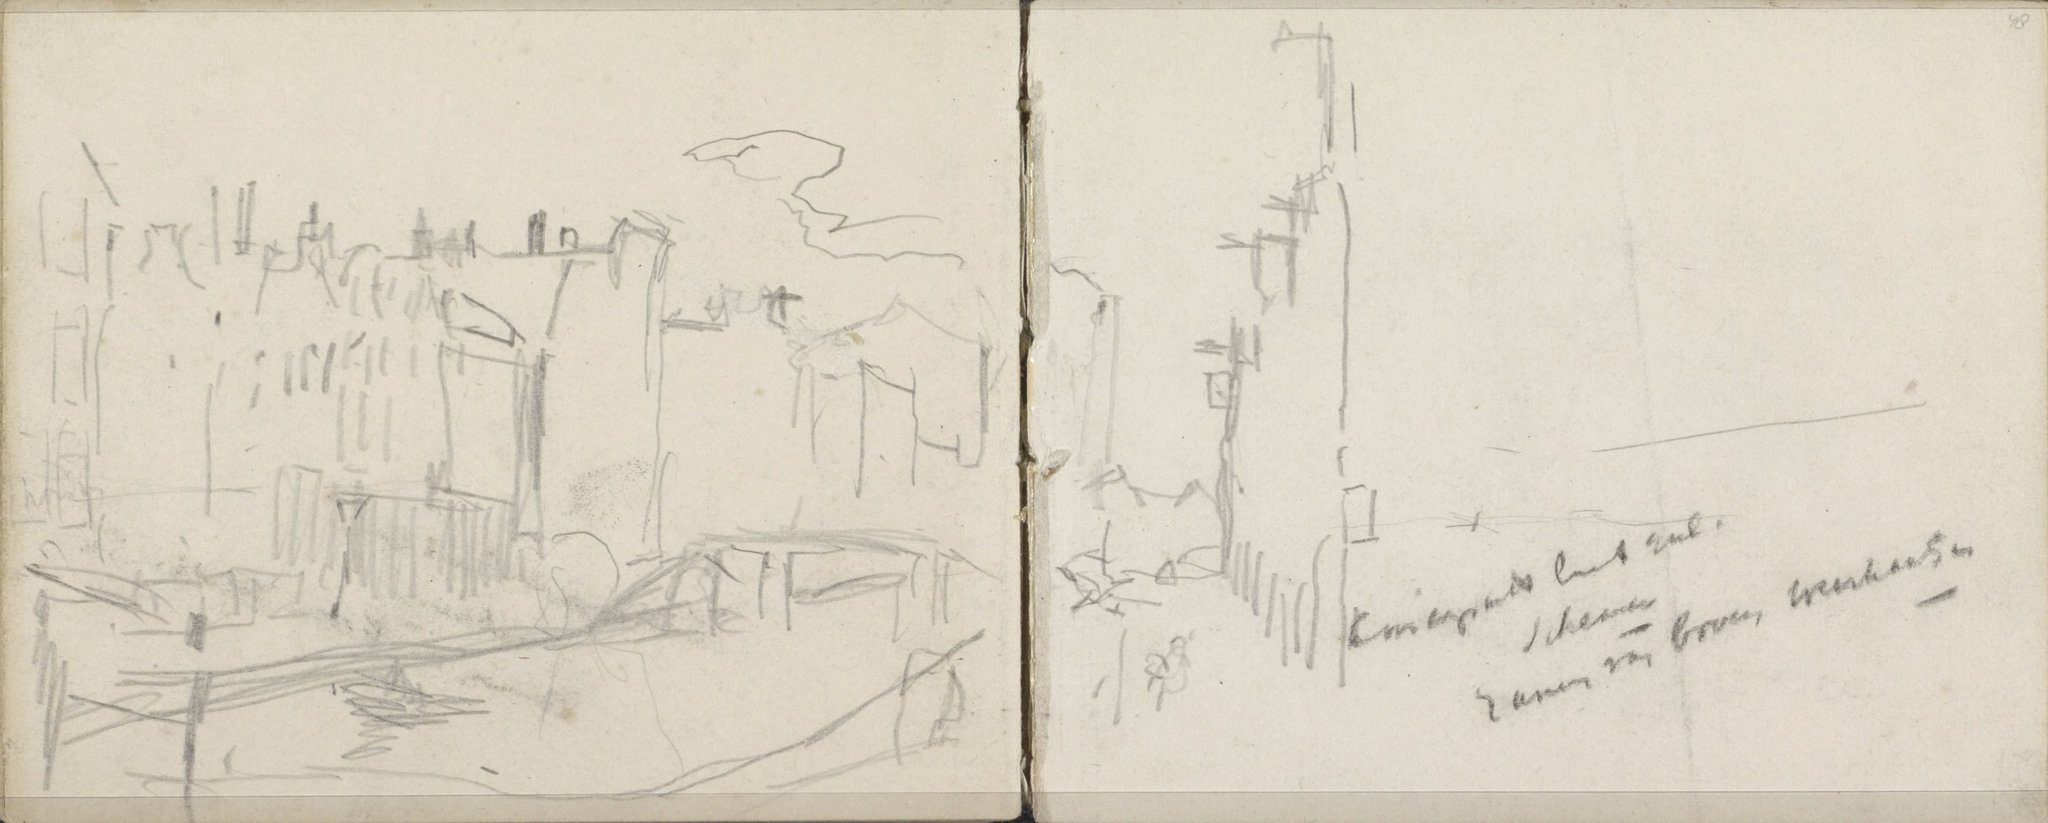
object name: sketchbook leaf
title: Looiersgracht te Amsterdam bij avond, gezien vanaf de Prinsengracht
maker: george hendrik breitner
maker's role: draughtsman, painter, print maker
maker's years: 1857-1923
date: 1886-1891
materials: paper, pencil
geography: amsterdam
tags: urban housing, canals, waters (in city)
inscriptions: annotation: ‘Looiergracht [sic] licht geel./ schemer/ ramen van boven weerkaatsen’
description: Pagina 47 en pagina 48 uit een schetsboek met 32 bladen.